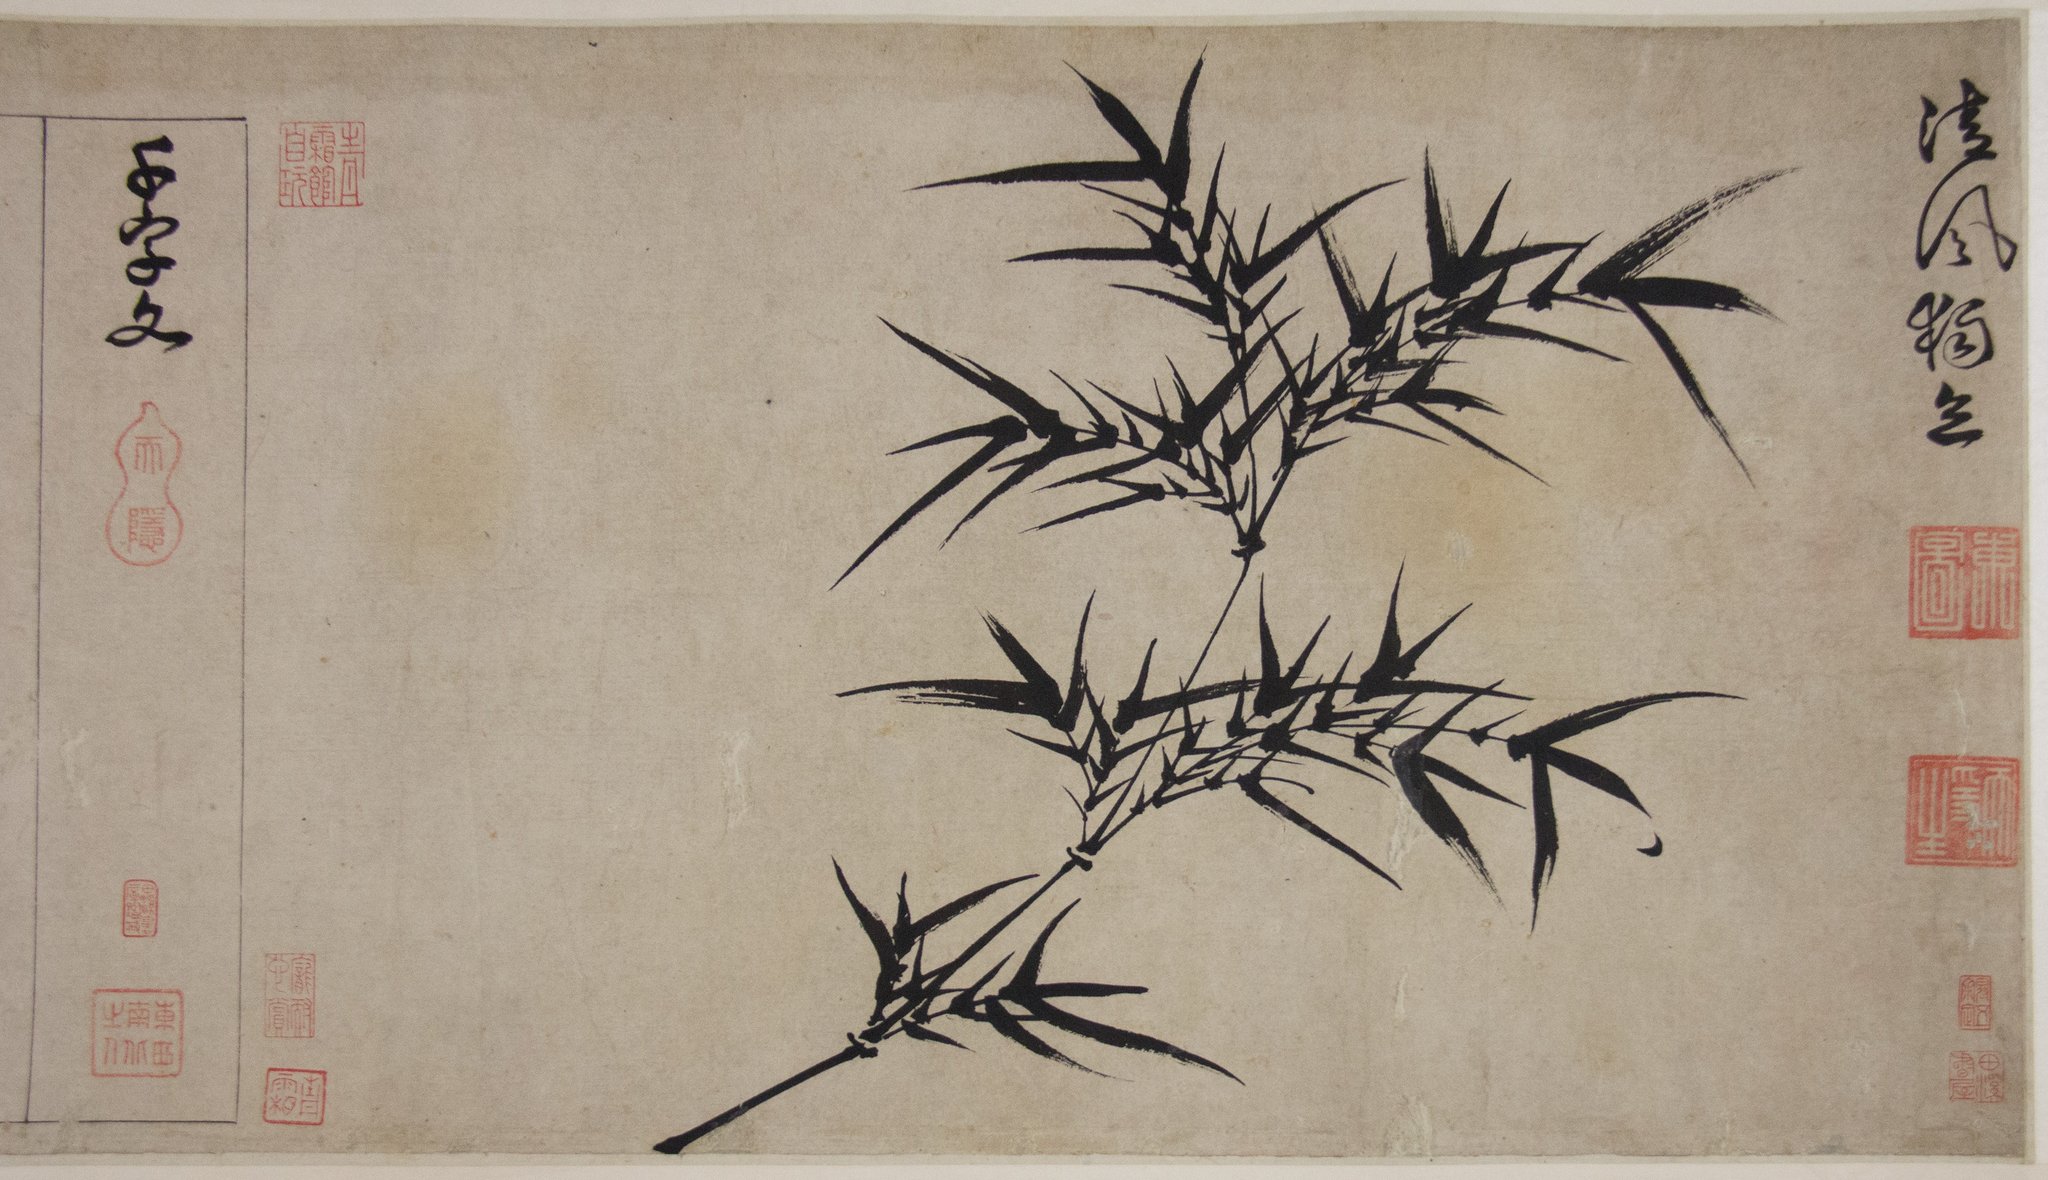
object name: handscroll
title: Thousand Character Classic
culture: chinese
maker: zhan jingfeng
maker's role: artist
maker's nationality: chinese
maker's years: 1520-1602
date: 1599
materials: ink, paper